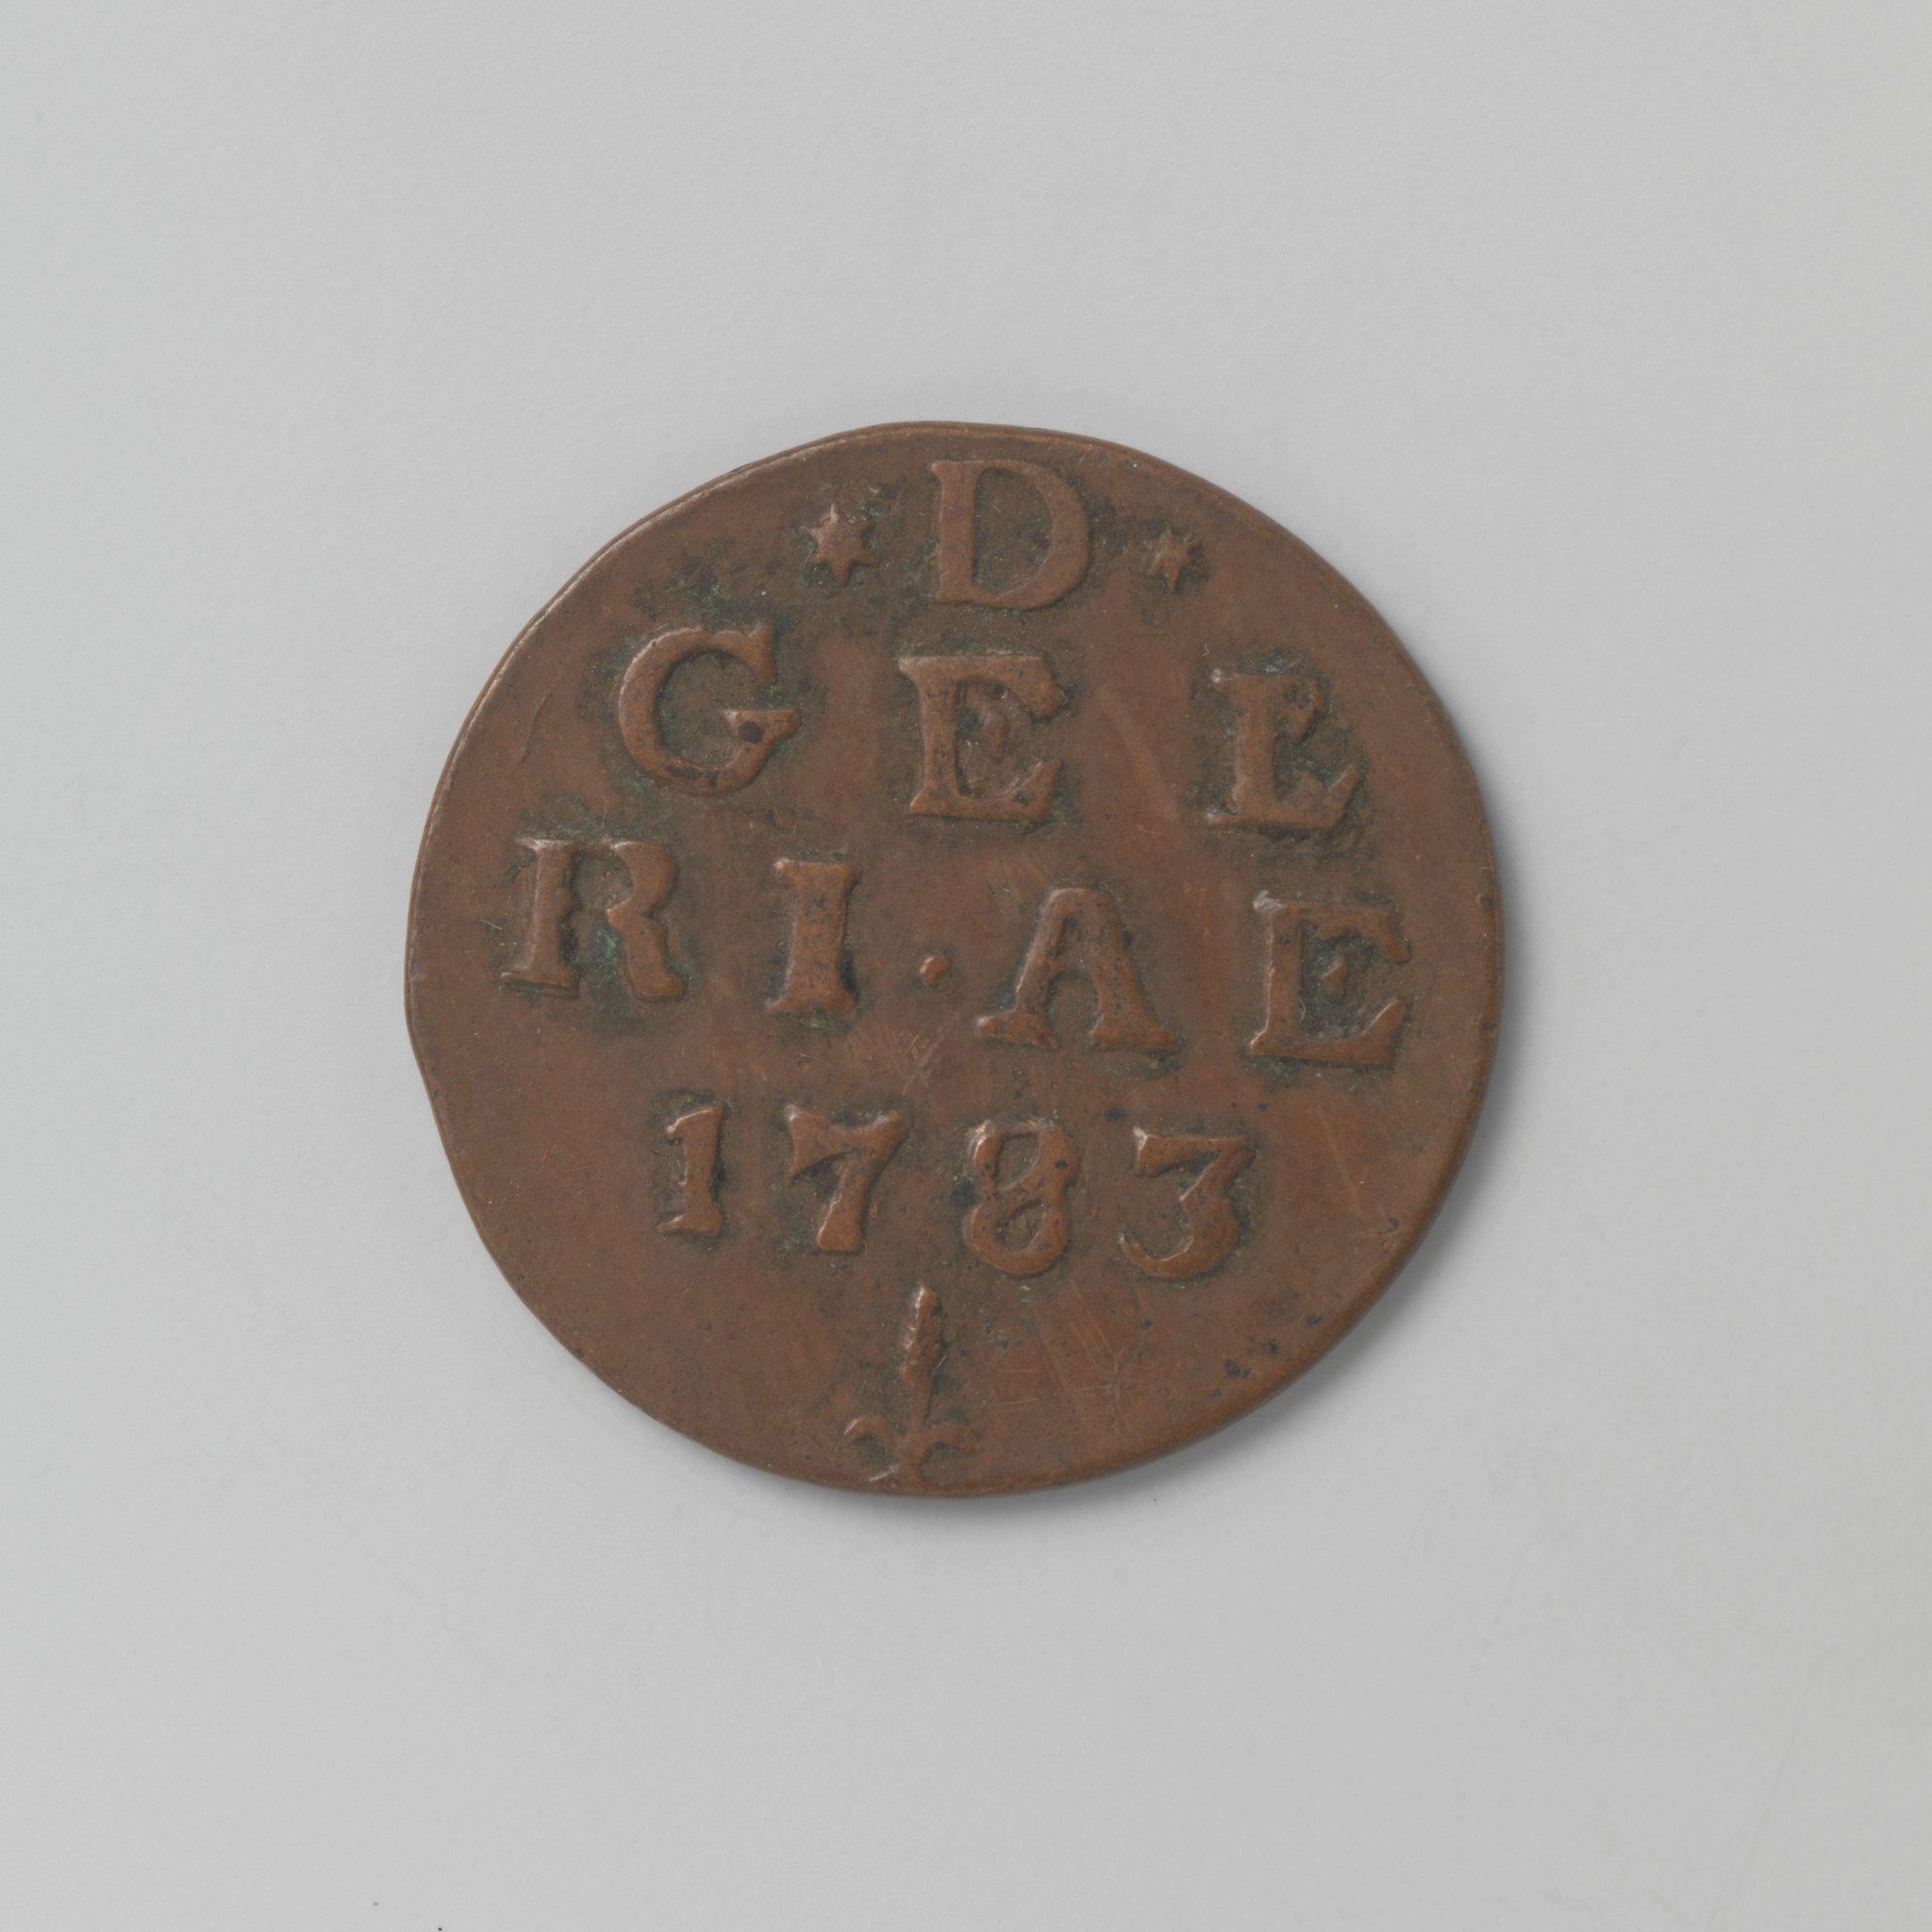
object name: duit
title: Gelderse duit, 1783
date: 1783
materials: copper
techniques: striking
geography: harderwijk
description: Koperen munt. Voorzijde: in drie regels D/GEL/RIAE, daaronder jaartal en muntmeesterteken. Keerzijde: gekroond Gelders wapenschild.